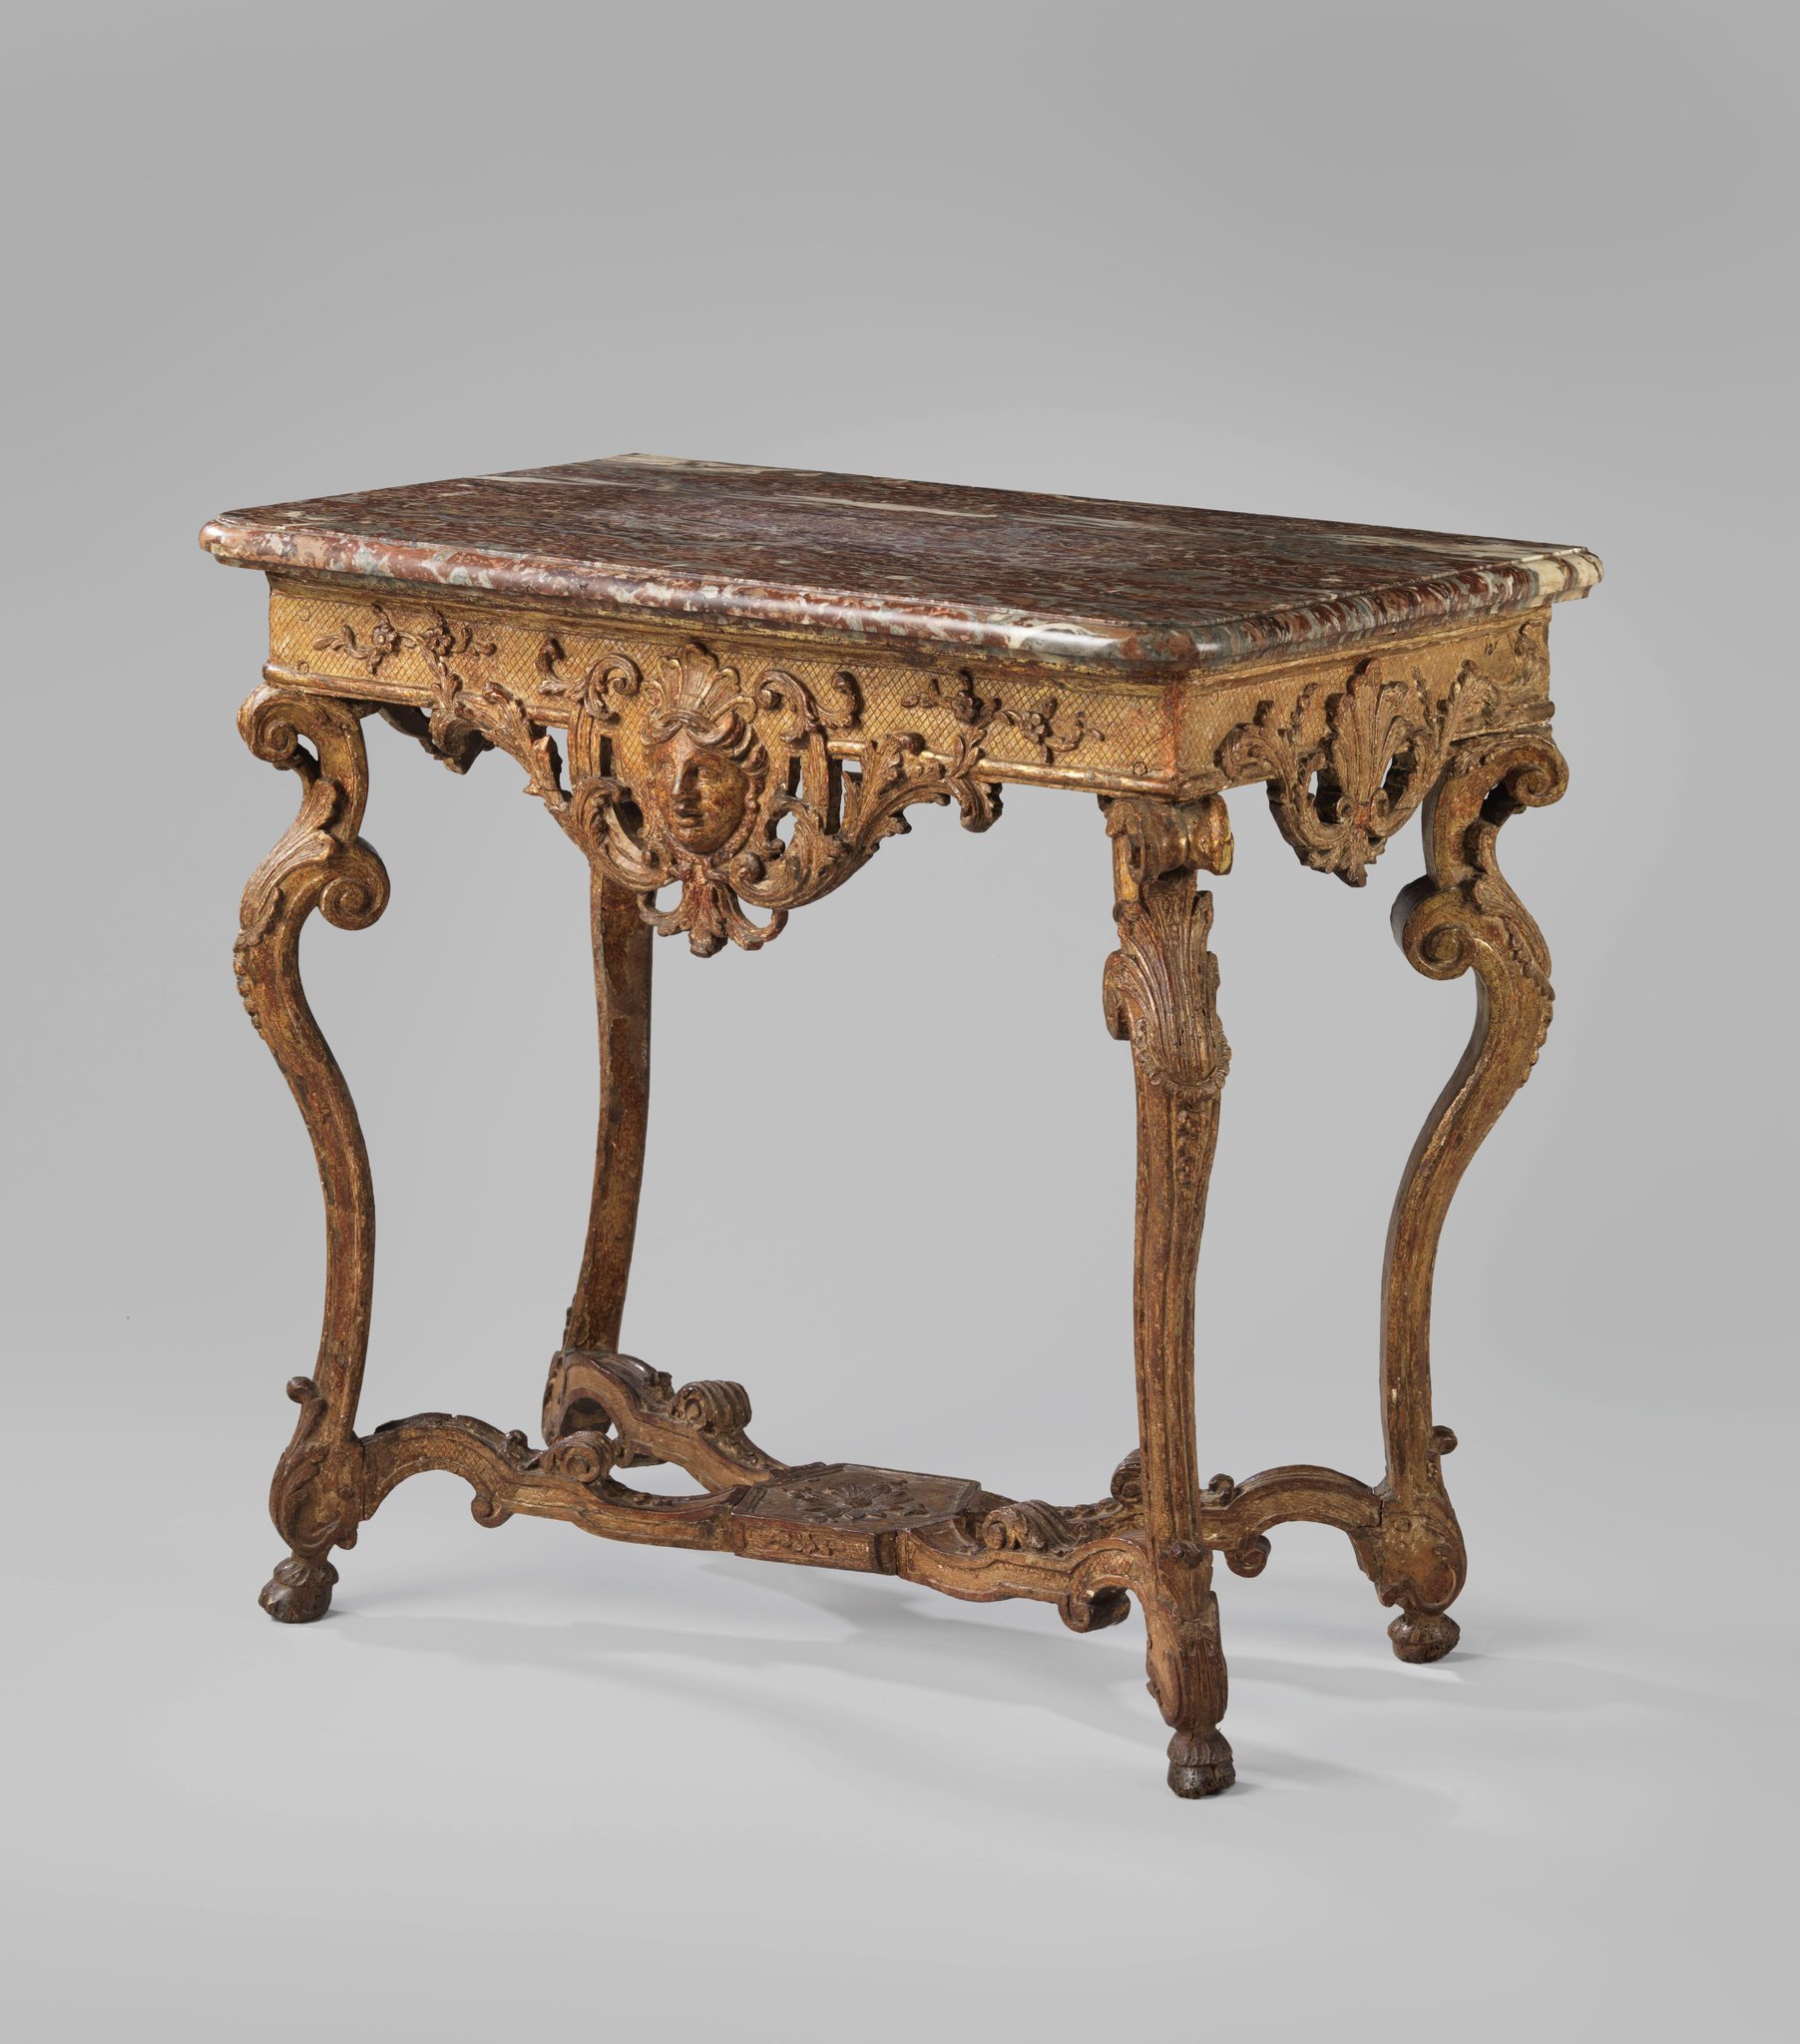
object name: wandtafel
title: Wandtafel van verguld eikenhout met rood geaderd marmeren blad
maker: Anonymous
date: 1700-1725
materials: marble, wood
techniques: gilding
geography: france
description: Wandtafel van verguld eikenhout. De overhoeks geplaatste poten rusten op hoeven en bestaan, evenals het X-vormig kruis, uit voluten, versierd met acanthusbladeren en klokjessnoeren; op het kruispunt een rozet in zeshoek. De tafelregels vertonen op geruit fond aan de voorkant een vrouwenkop tussen acanthusbladeren en bloemtakjes, en opzij een palmet tussen acanthusbladeren. De tafel heeft een rood geaderd marmeren blad met aan de voorkant en de zijkanten een geprofileerde rand.